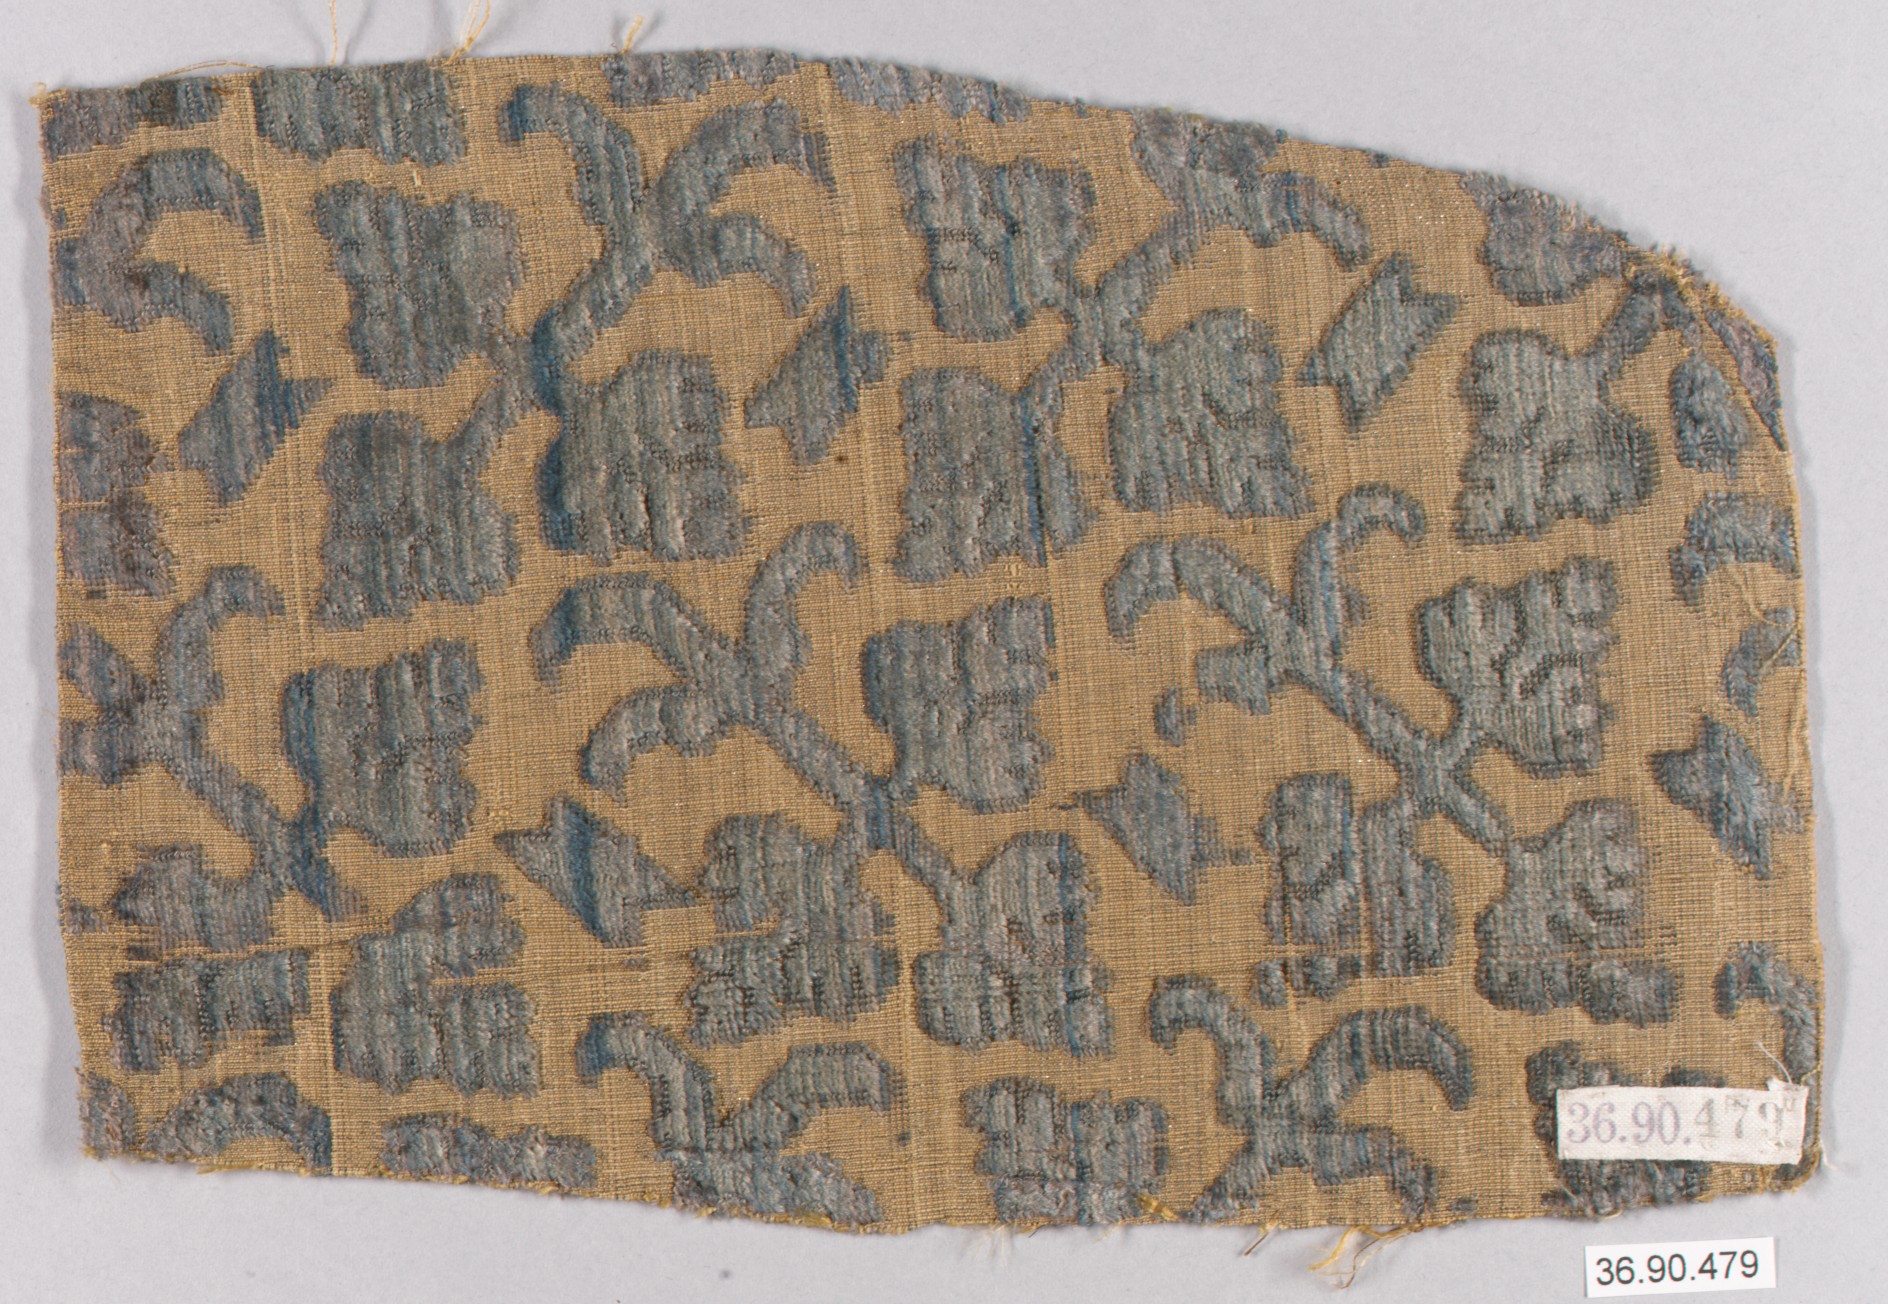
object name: piece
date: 1501-1700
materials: metal thread, silk